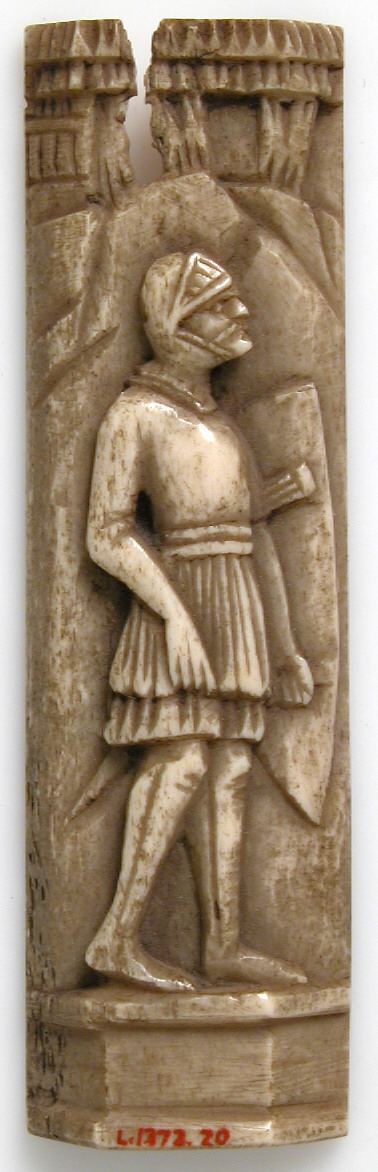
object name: panel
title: Panel with Armored Soldier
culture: european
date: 1801-1900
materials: bone